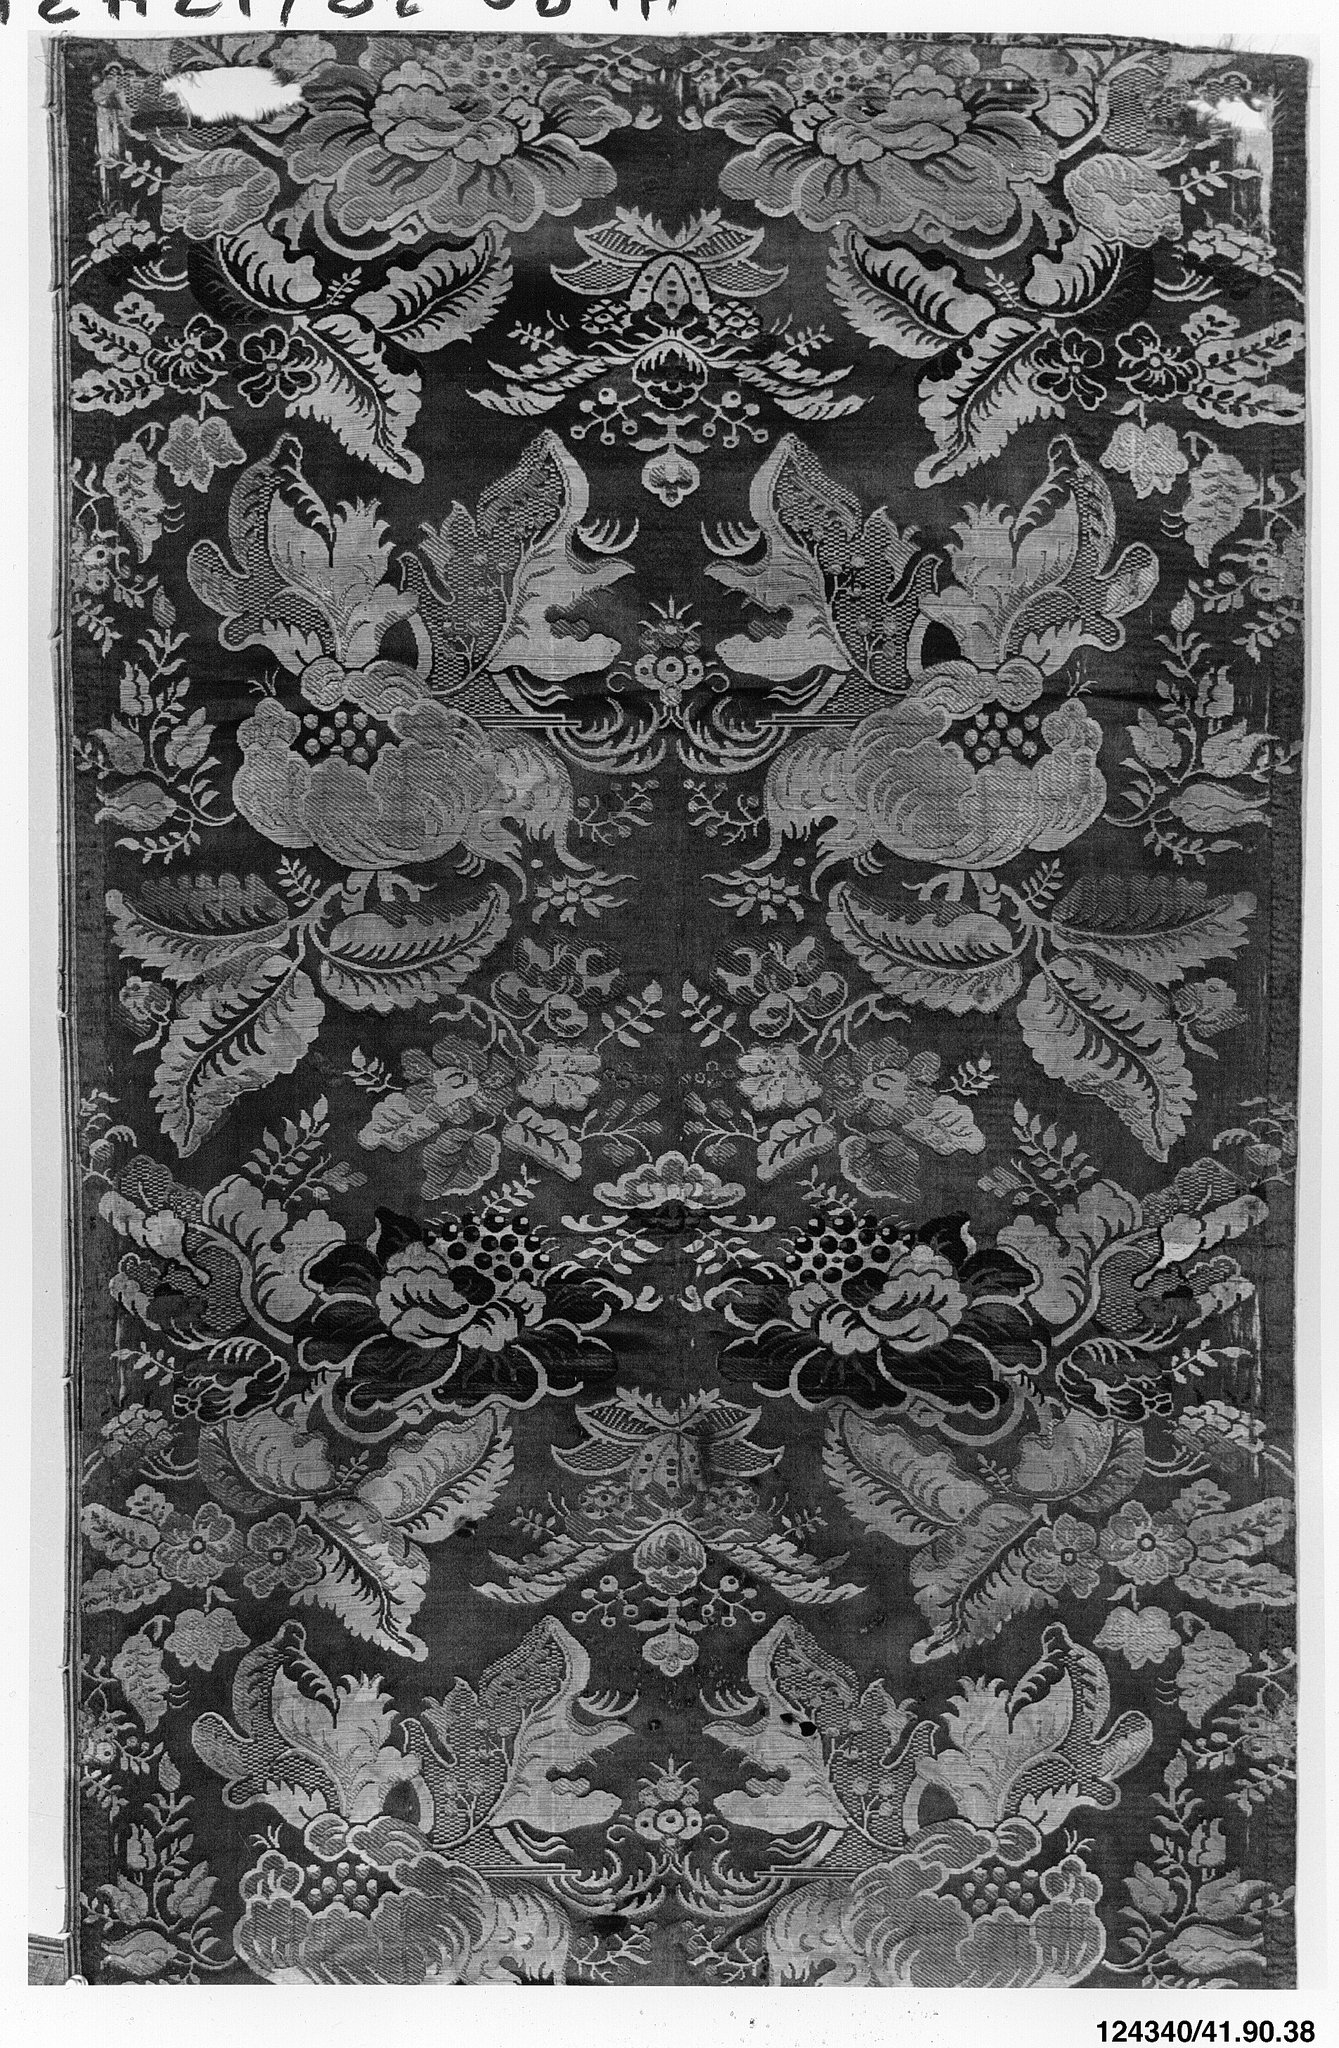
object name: piece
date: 1730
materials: silk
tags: flowers,leaves